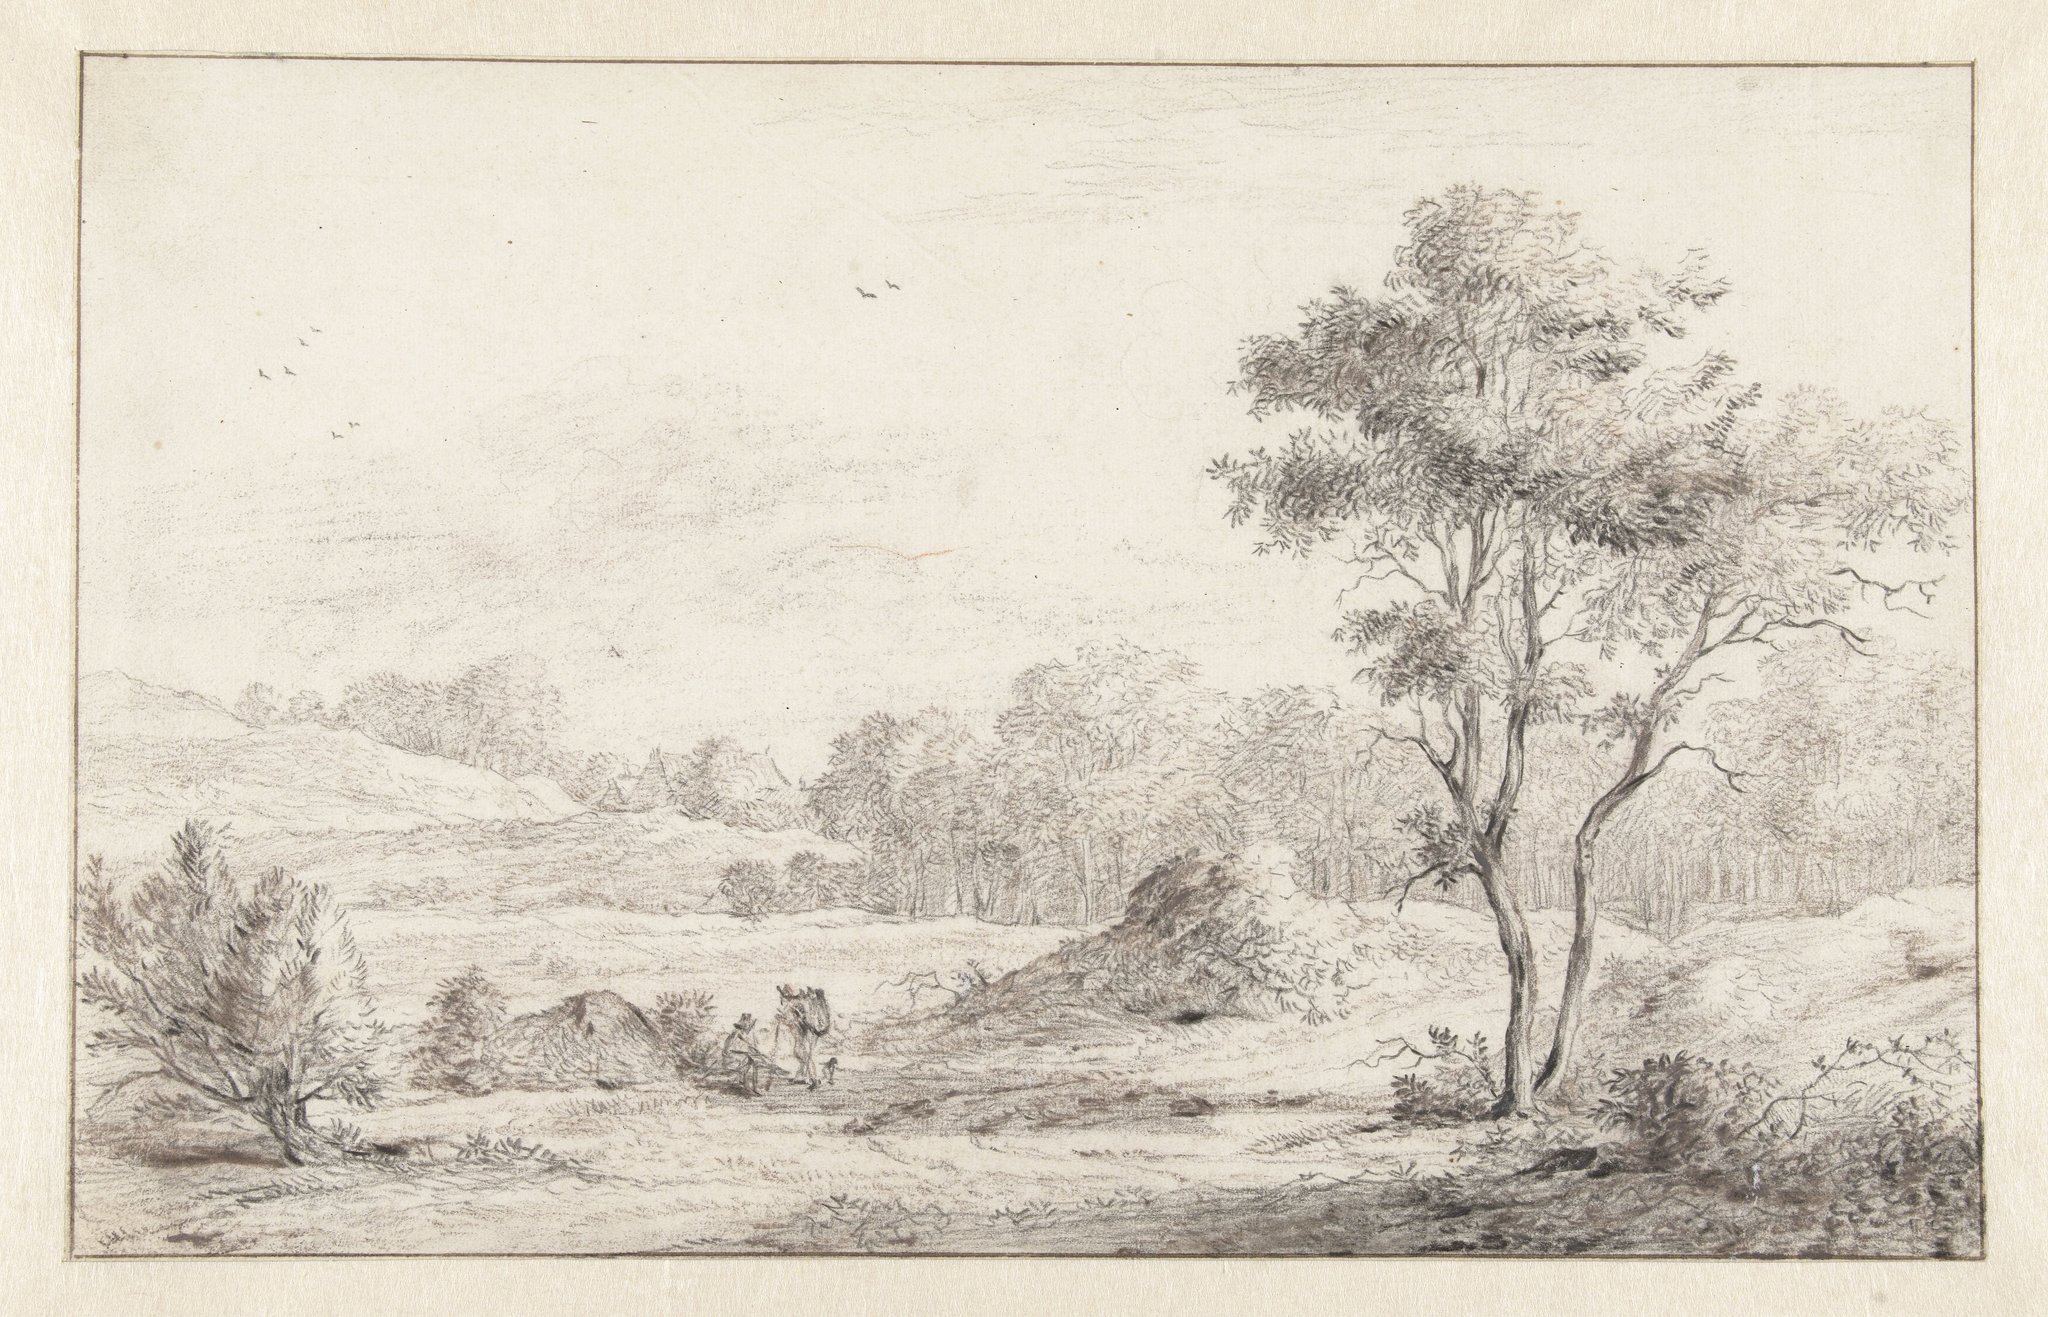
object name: drawing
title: Duinlandschap achter de bleekerij van De Mol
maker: jan vincentsz. van der vinne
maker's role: draughtsman, print maker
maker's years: 1663-1721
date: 1677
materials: chalk, paper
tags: dunes (sea not visible); in the dunes, bleaching (laundering)